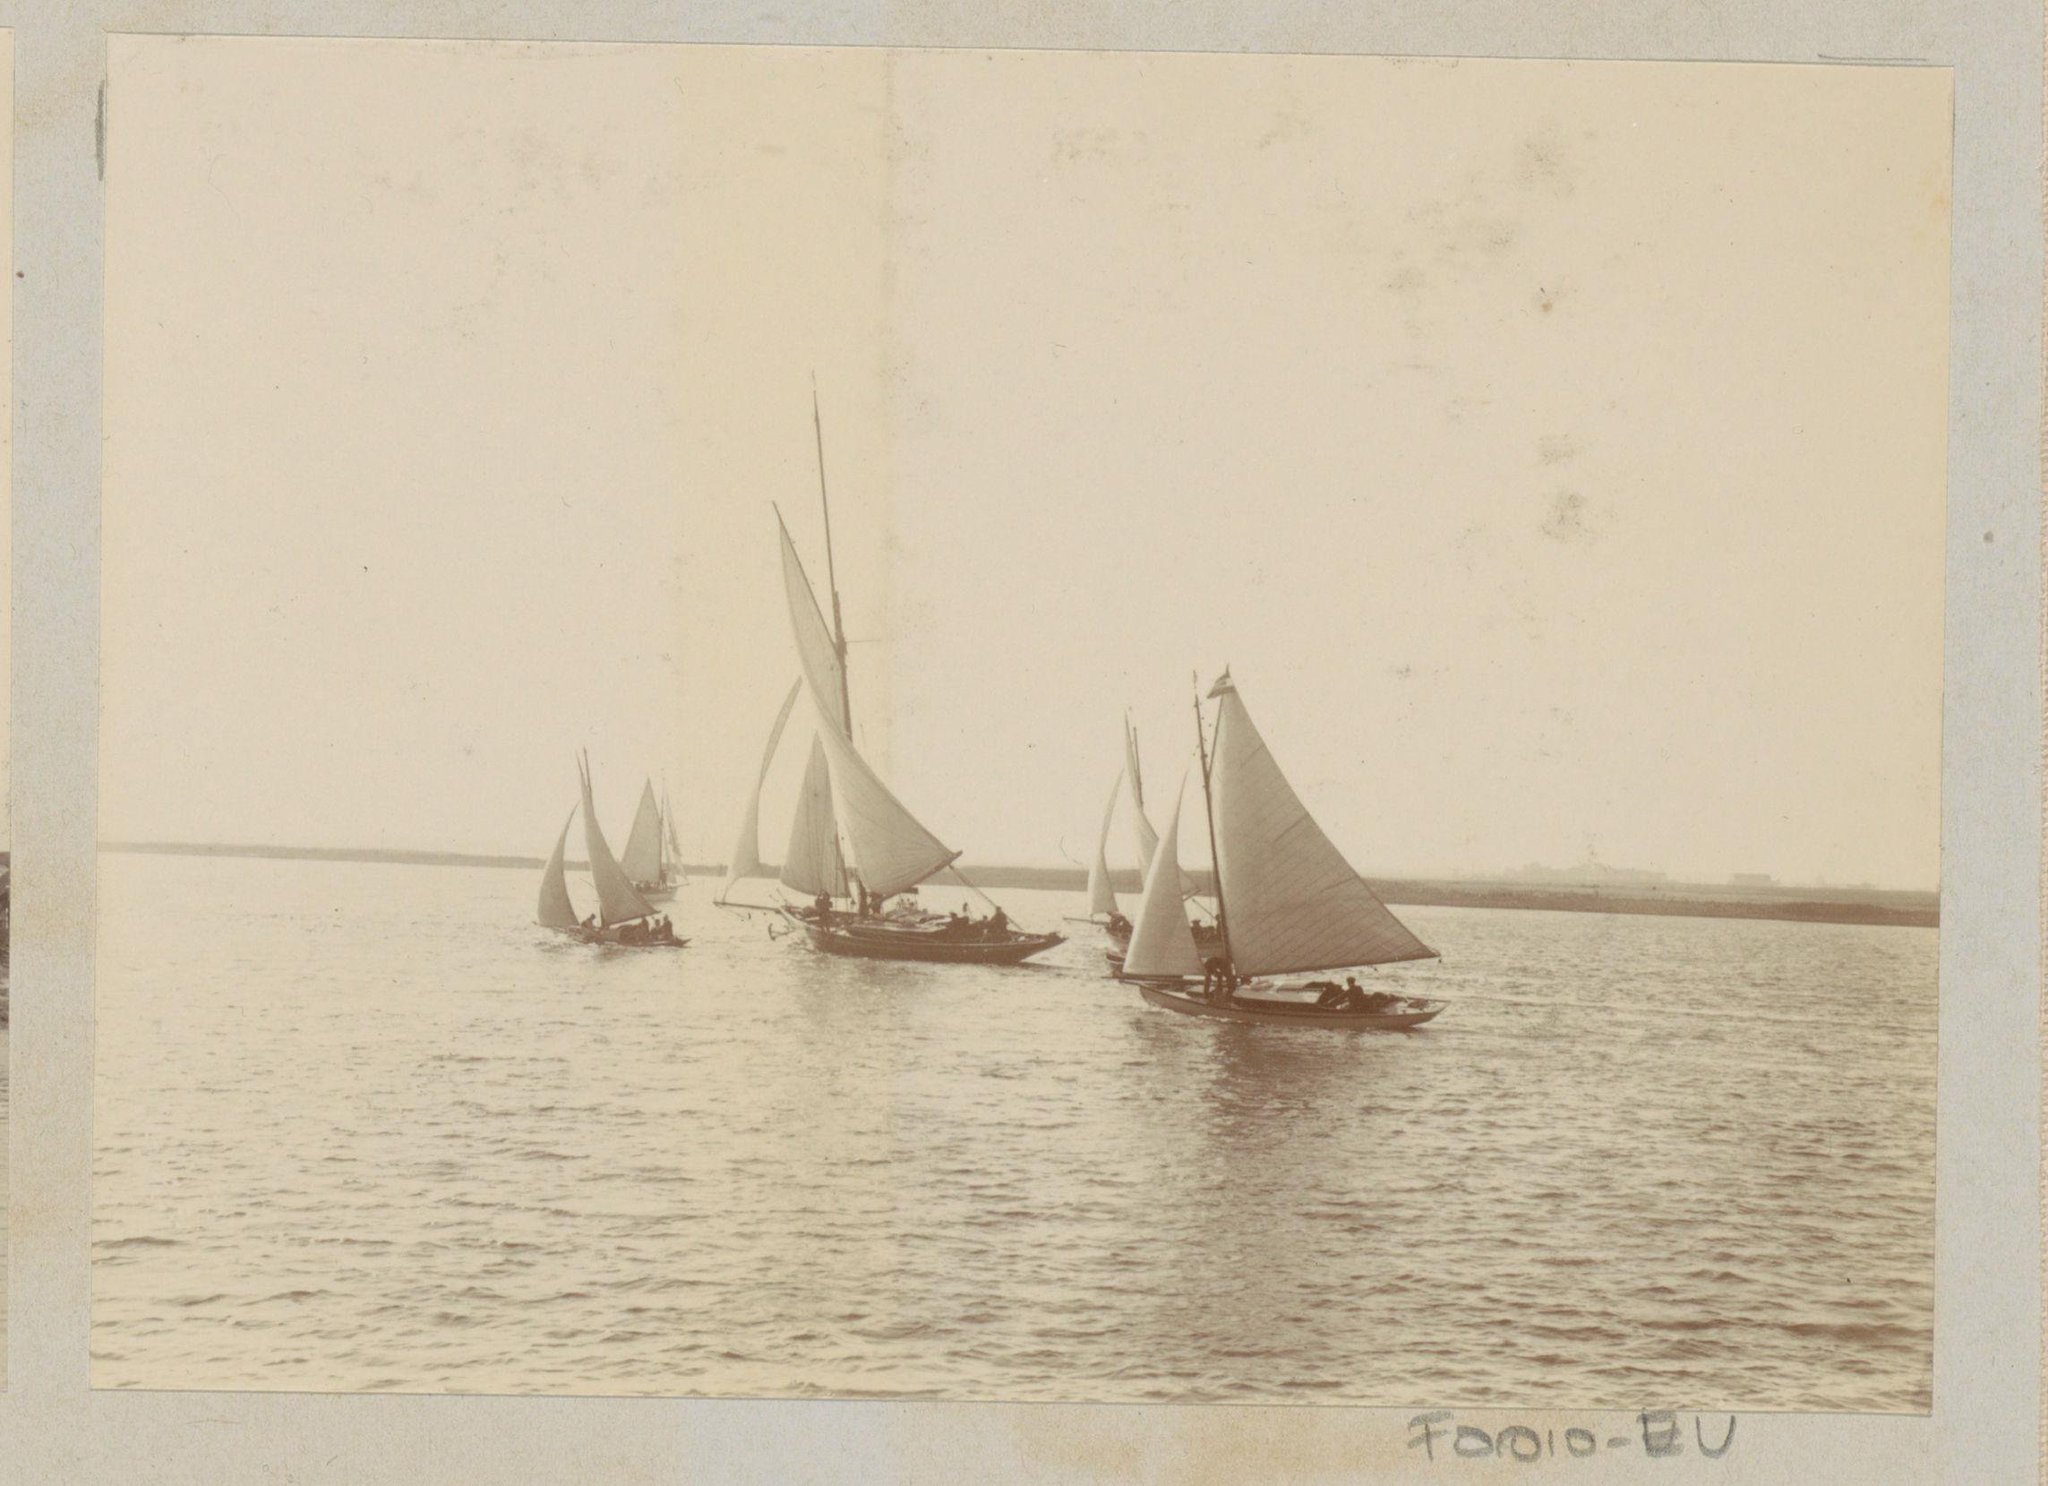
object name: photograph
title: Zeilschepen op het water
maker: Anonymous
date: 1900-1910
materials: photographic support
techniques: daylight paper print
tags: sailing-ship, sailing-boat, landscapes with waters, waterscapes, seascapes (in the temperate zone)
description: Onderdeel van Familiealbum met onder meer foto's van Wijnhandel Kraaij & Co. Bordeaux-Amsterdam.